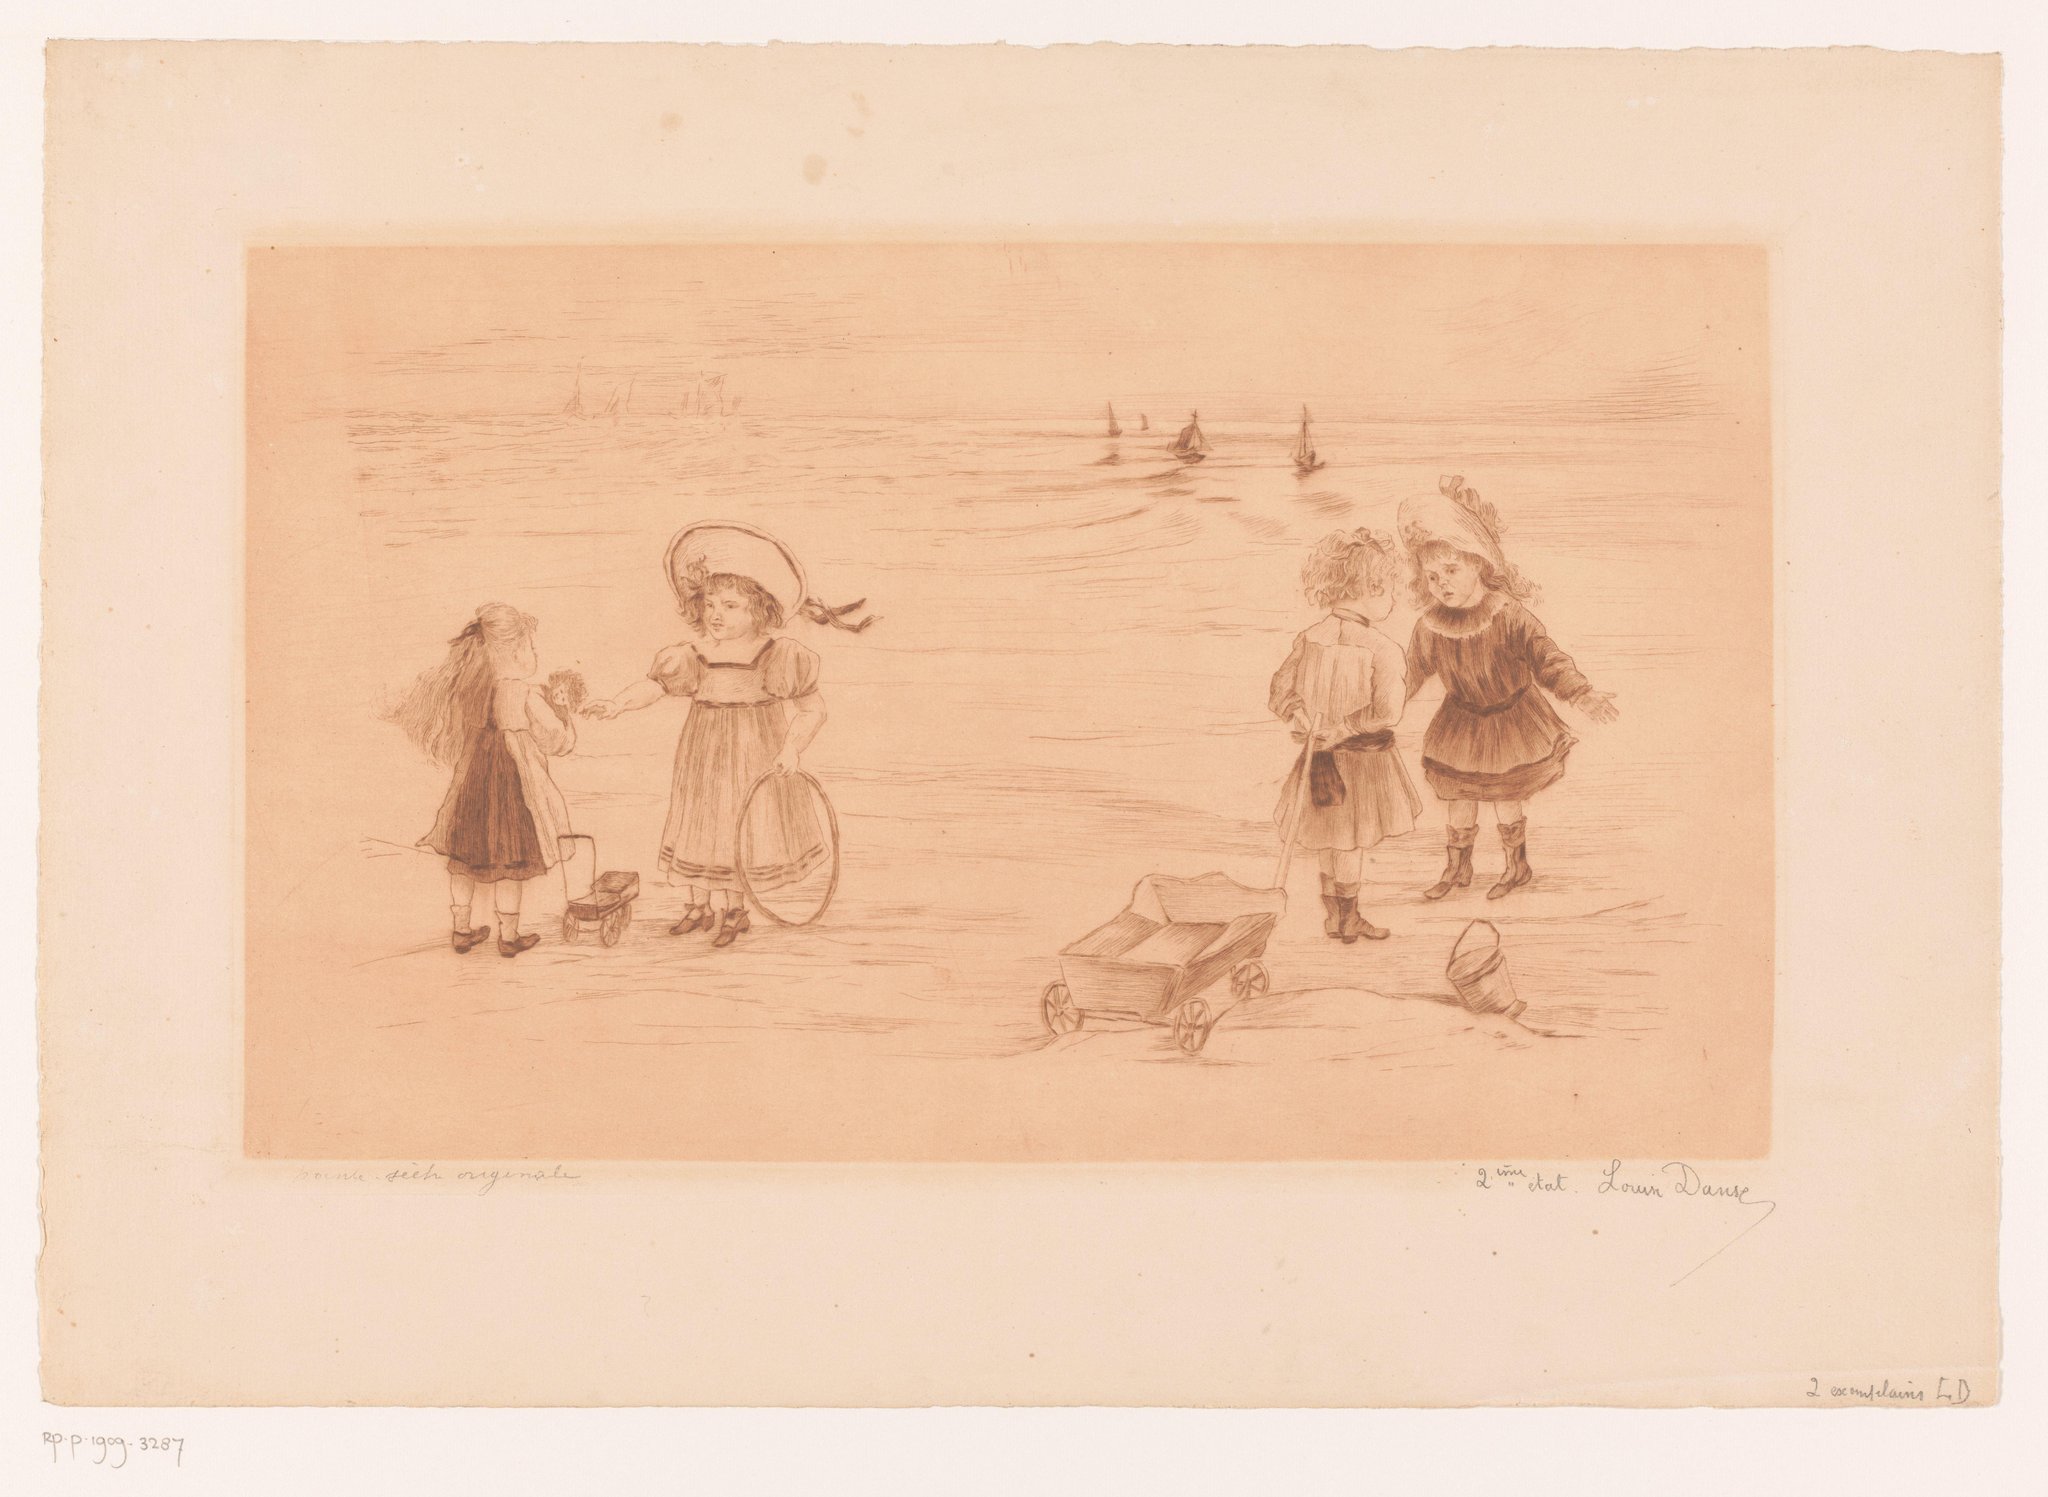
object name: print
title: Vier meisjes met speelgoed aan het strand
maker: louise danse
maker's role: painter, print maker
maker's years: 1867-1948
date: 1877-1909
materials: paper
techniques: drypoint, etching, intaglio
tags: in or beside the water (on the beach)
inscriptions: annotation: ‘pointe-sèche originale; 2ème état; 2 exemplaires L.D.’, collector's mark: Lugt 2228